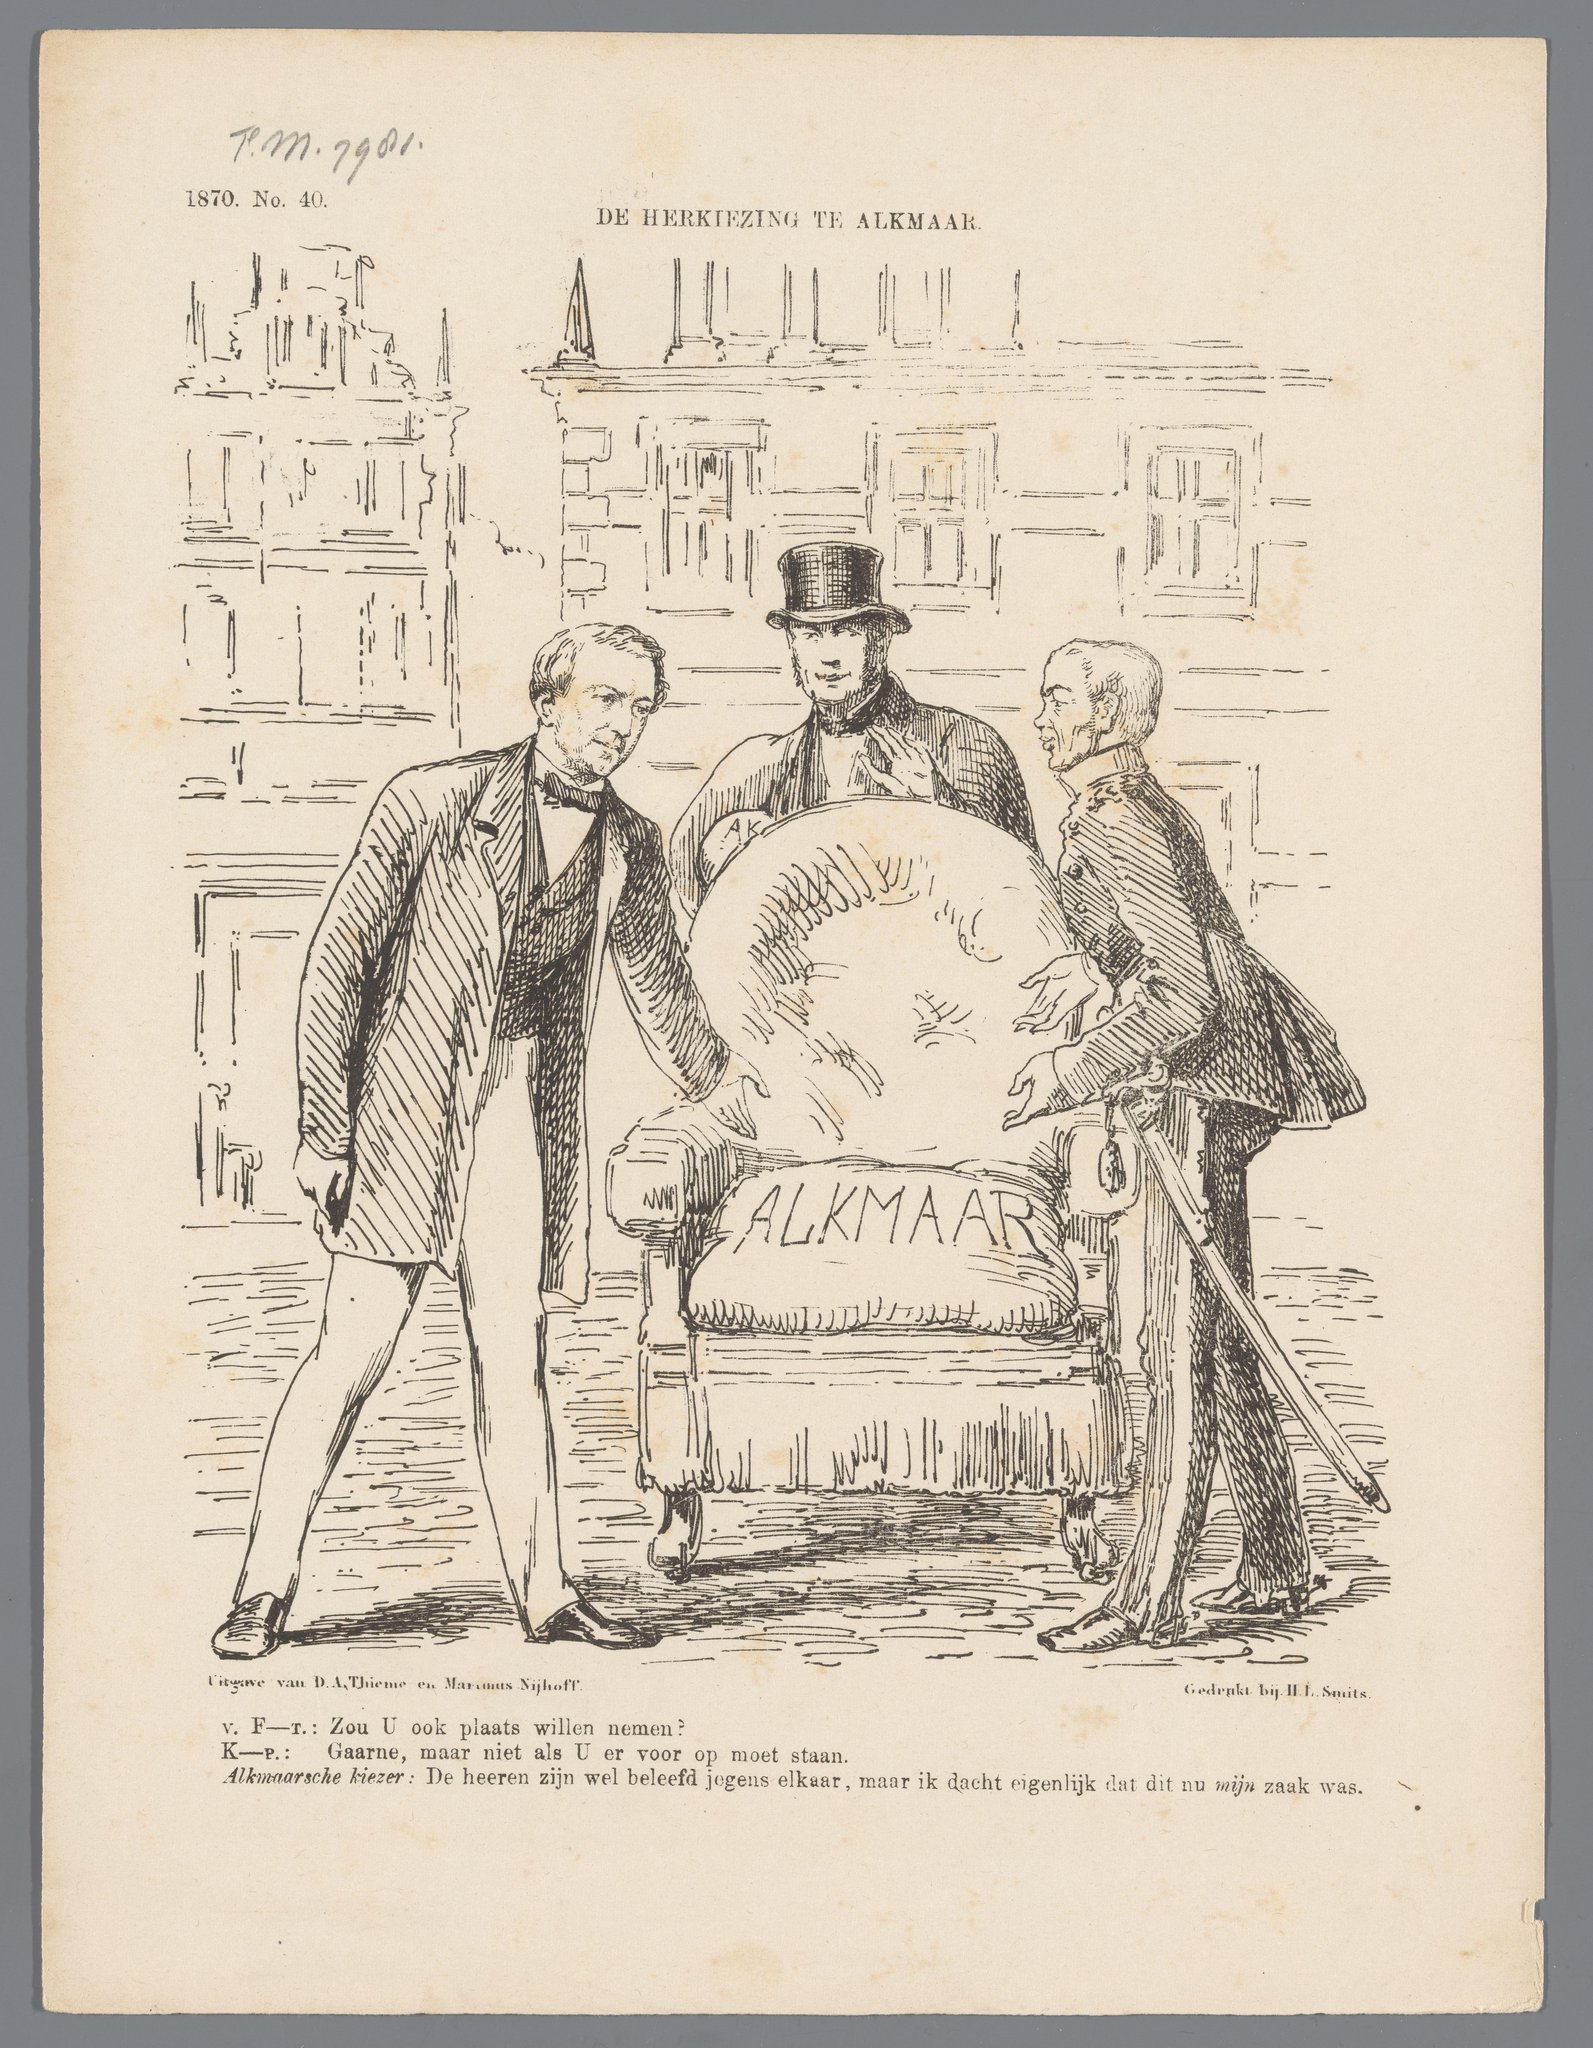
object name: print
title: Spotprent rond de herverkiezing te Alkmaar, 1870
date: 1870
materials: paper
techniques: lithograph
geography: netherlands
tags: kamerlid, cornelis van foreest, generaal, willem jan knoop, alkmaar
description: Spotprent rond de herverkiezingen te Alkmaar. De jhr. van Foreest en generaal Knoop aan weerszijden van de zetel Alkmaar. Plaat verschenen bij het weekblad De Nederlandsche Spectator, nr. 40, 1870.